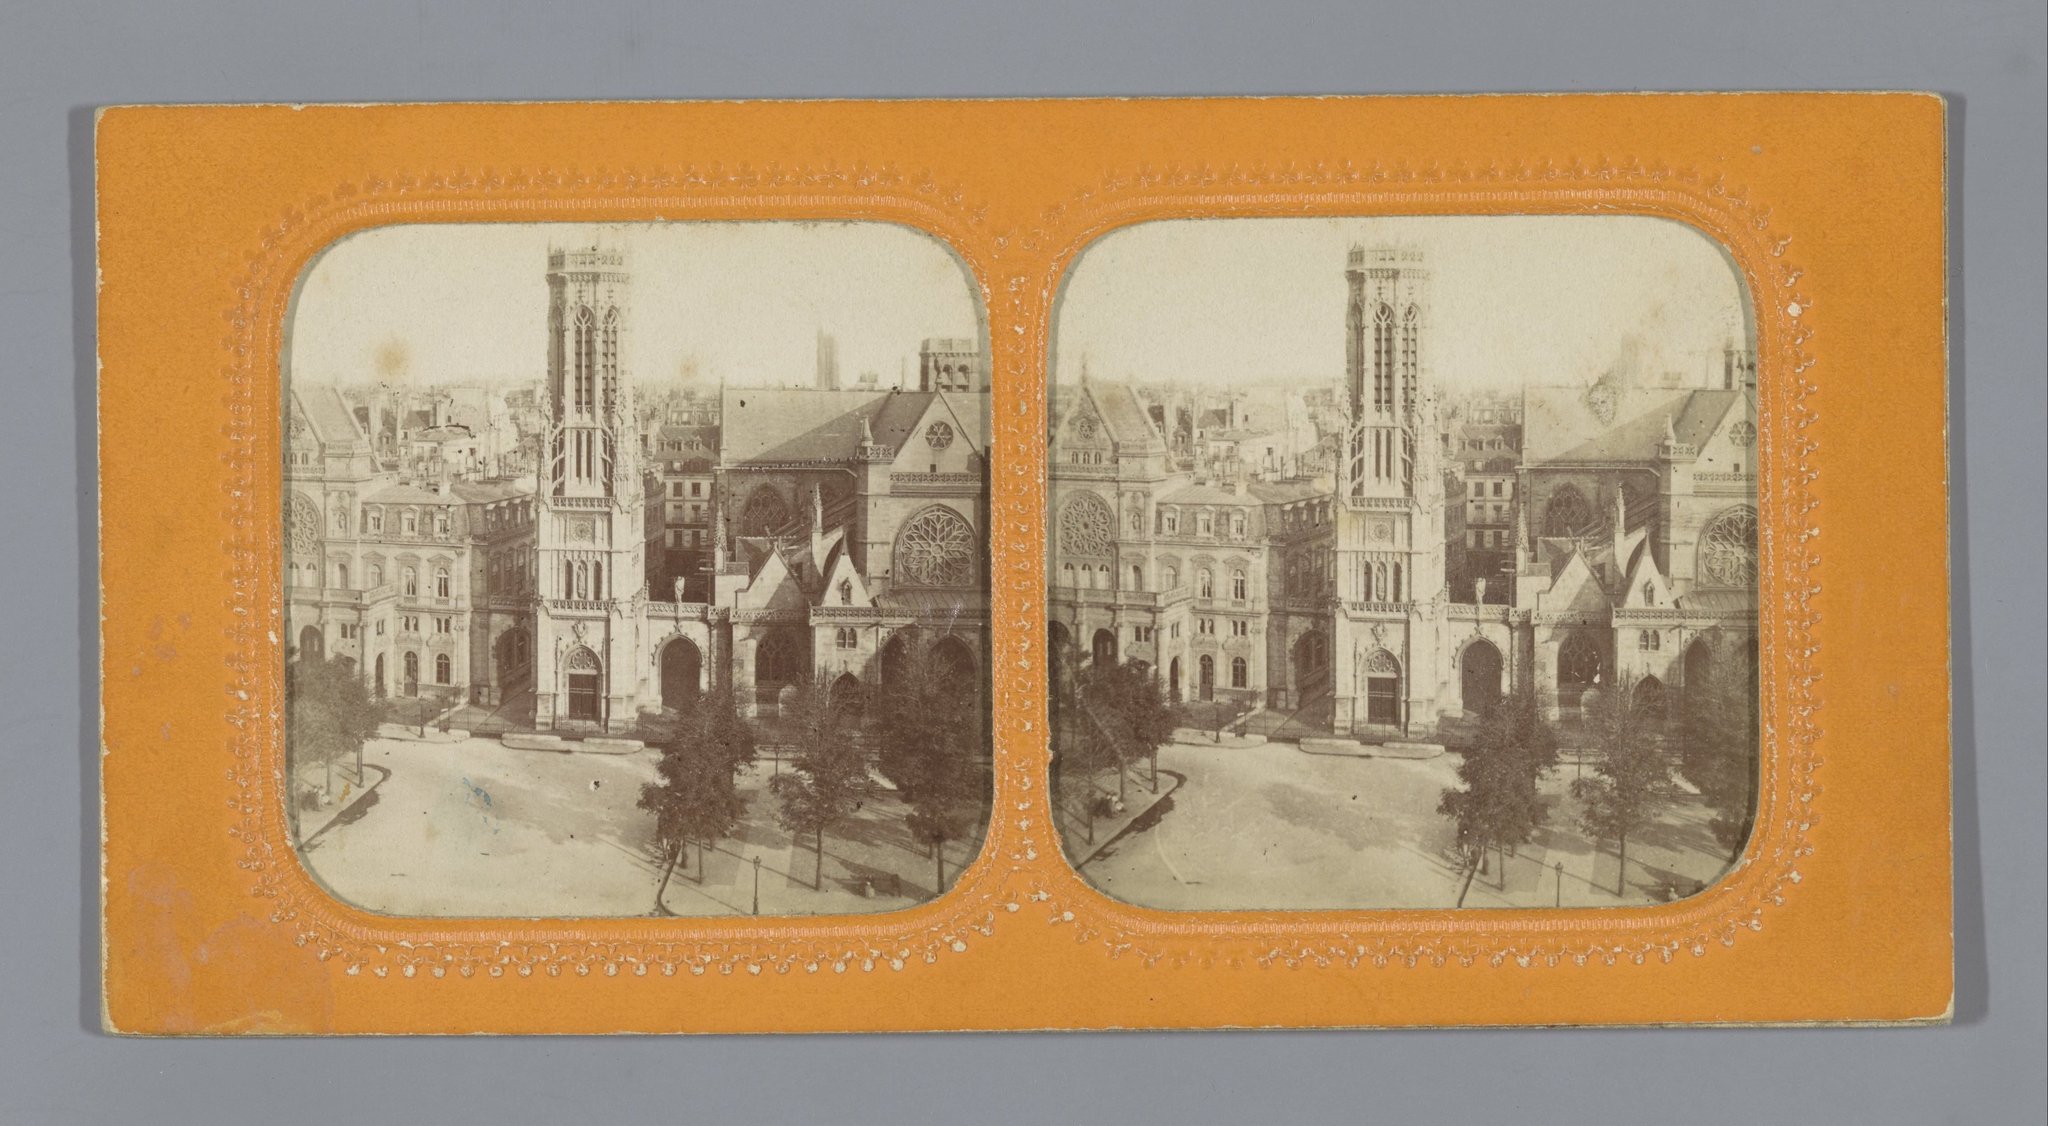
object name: tissue stereograph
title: Kerk St. Germain l'Auxerrois / Eg. St. Germain L'Auxerrois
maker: Anonymous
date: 1855-1875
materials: cardboard, paper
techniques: albumen print, hand coloring, perforating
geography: paris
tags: square, place, circus, etc., church (exterior)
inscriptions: stamp: ‘J. C. DE BESTE Wz./ GOES’